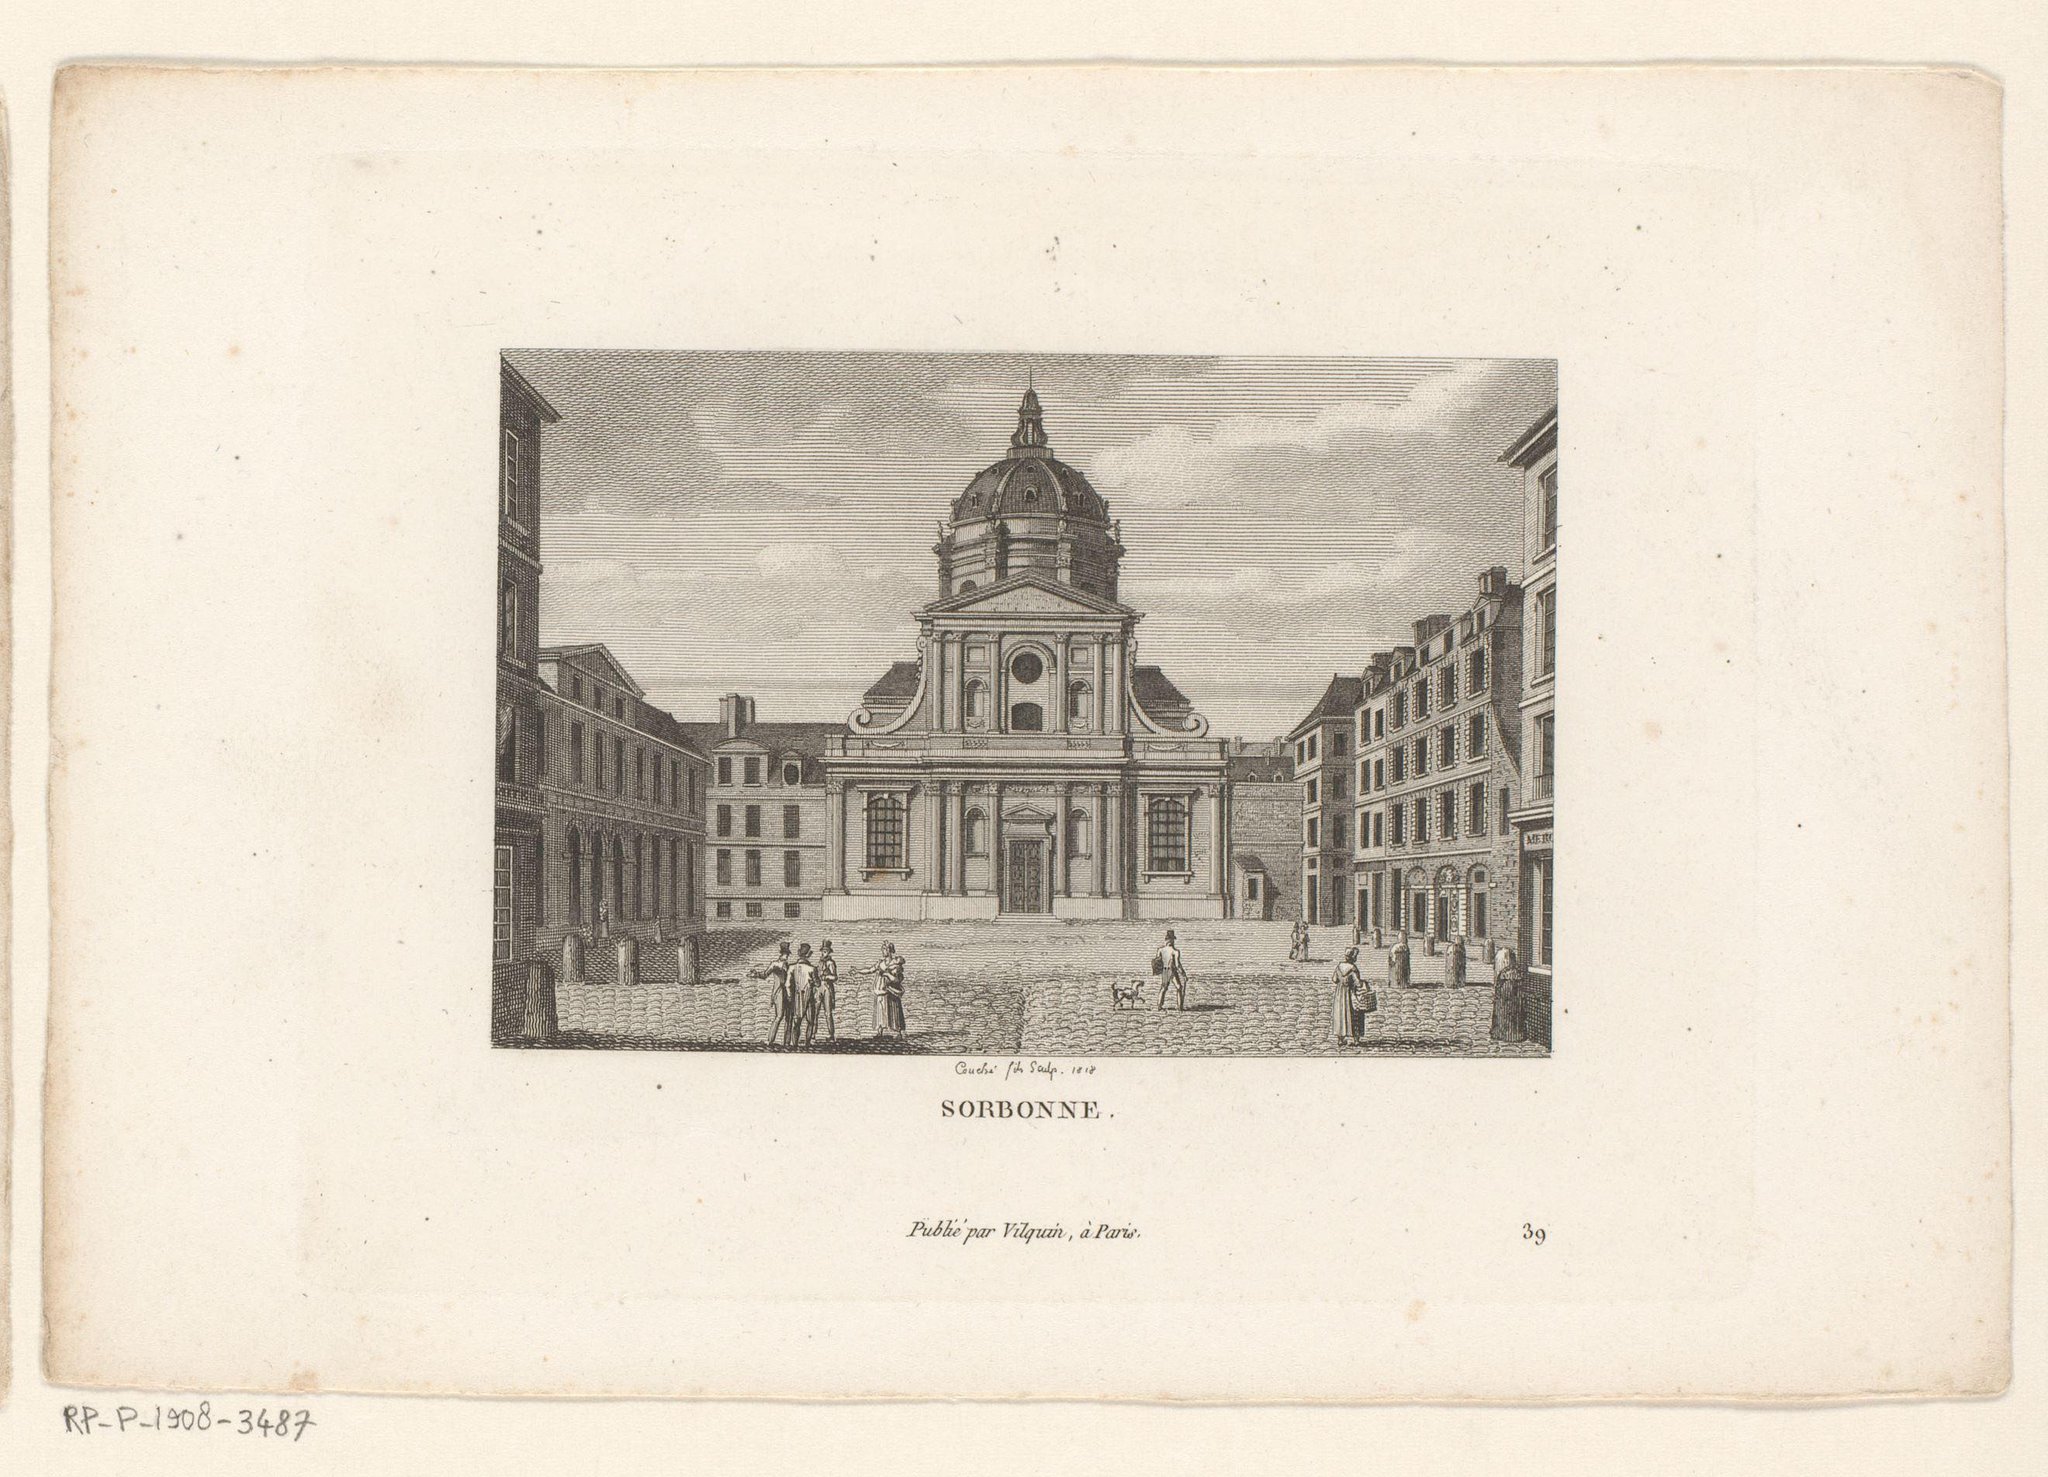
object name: print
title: Gezicht op de Sorbonne te Parijs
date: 1818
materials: paper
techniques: etching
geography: paris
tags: city-view in general; 'veduta', paris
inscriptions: collector's mark: Lugt 2228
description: Maakt deel uit van een serie met 60 platen van monumenten, kathedralen en paleizen in Parijs.